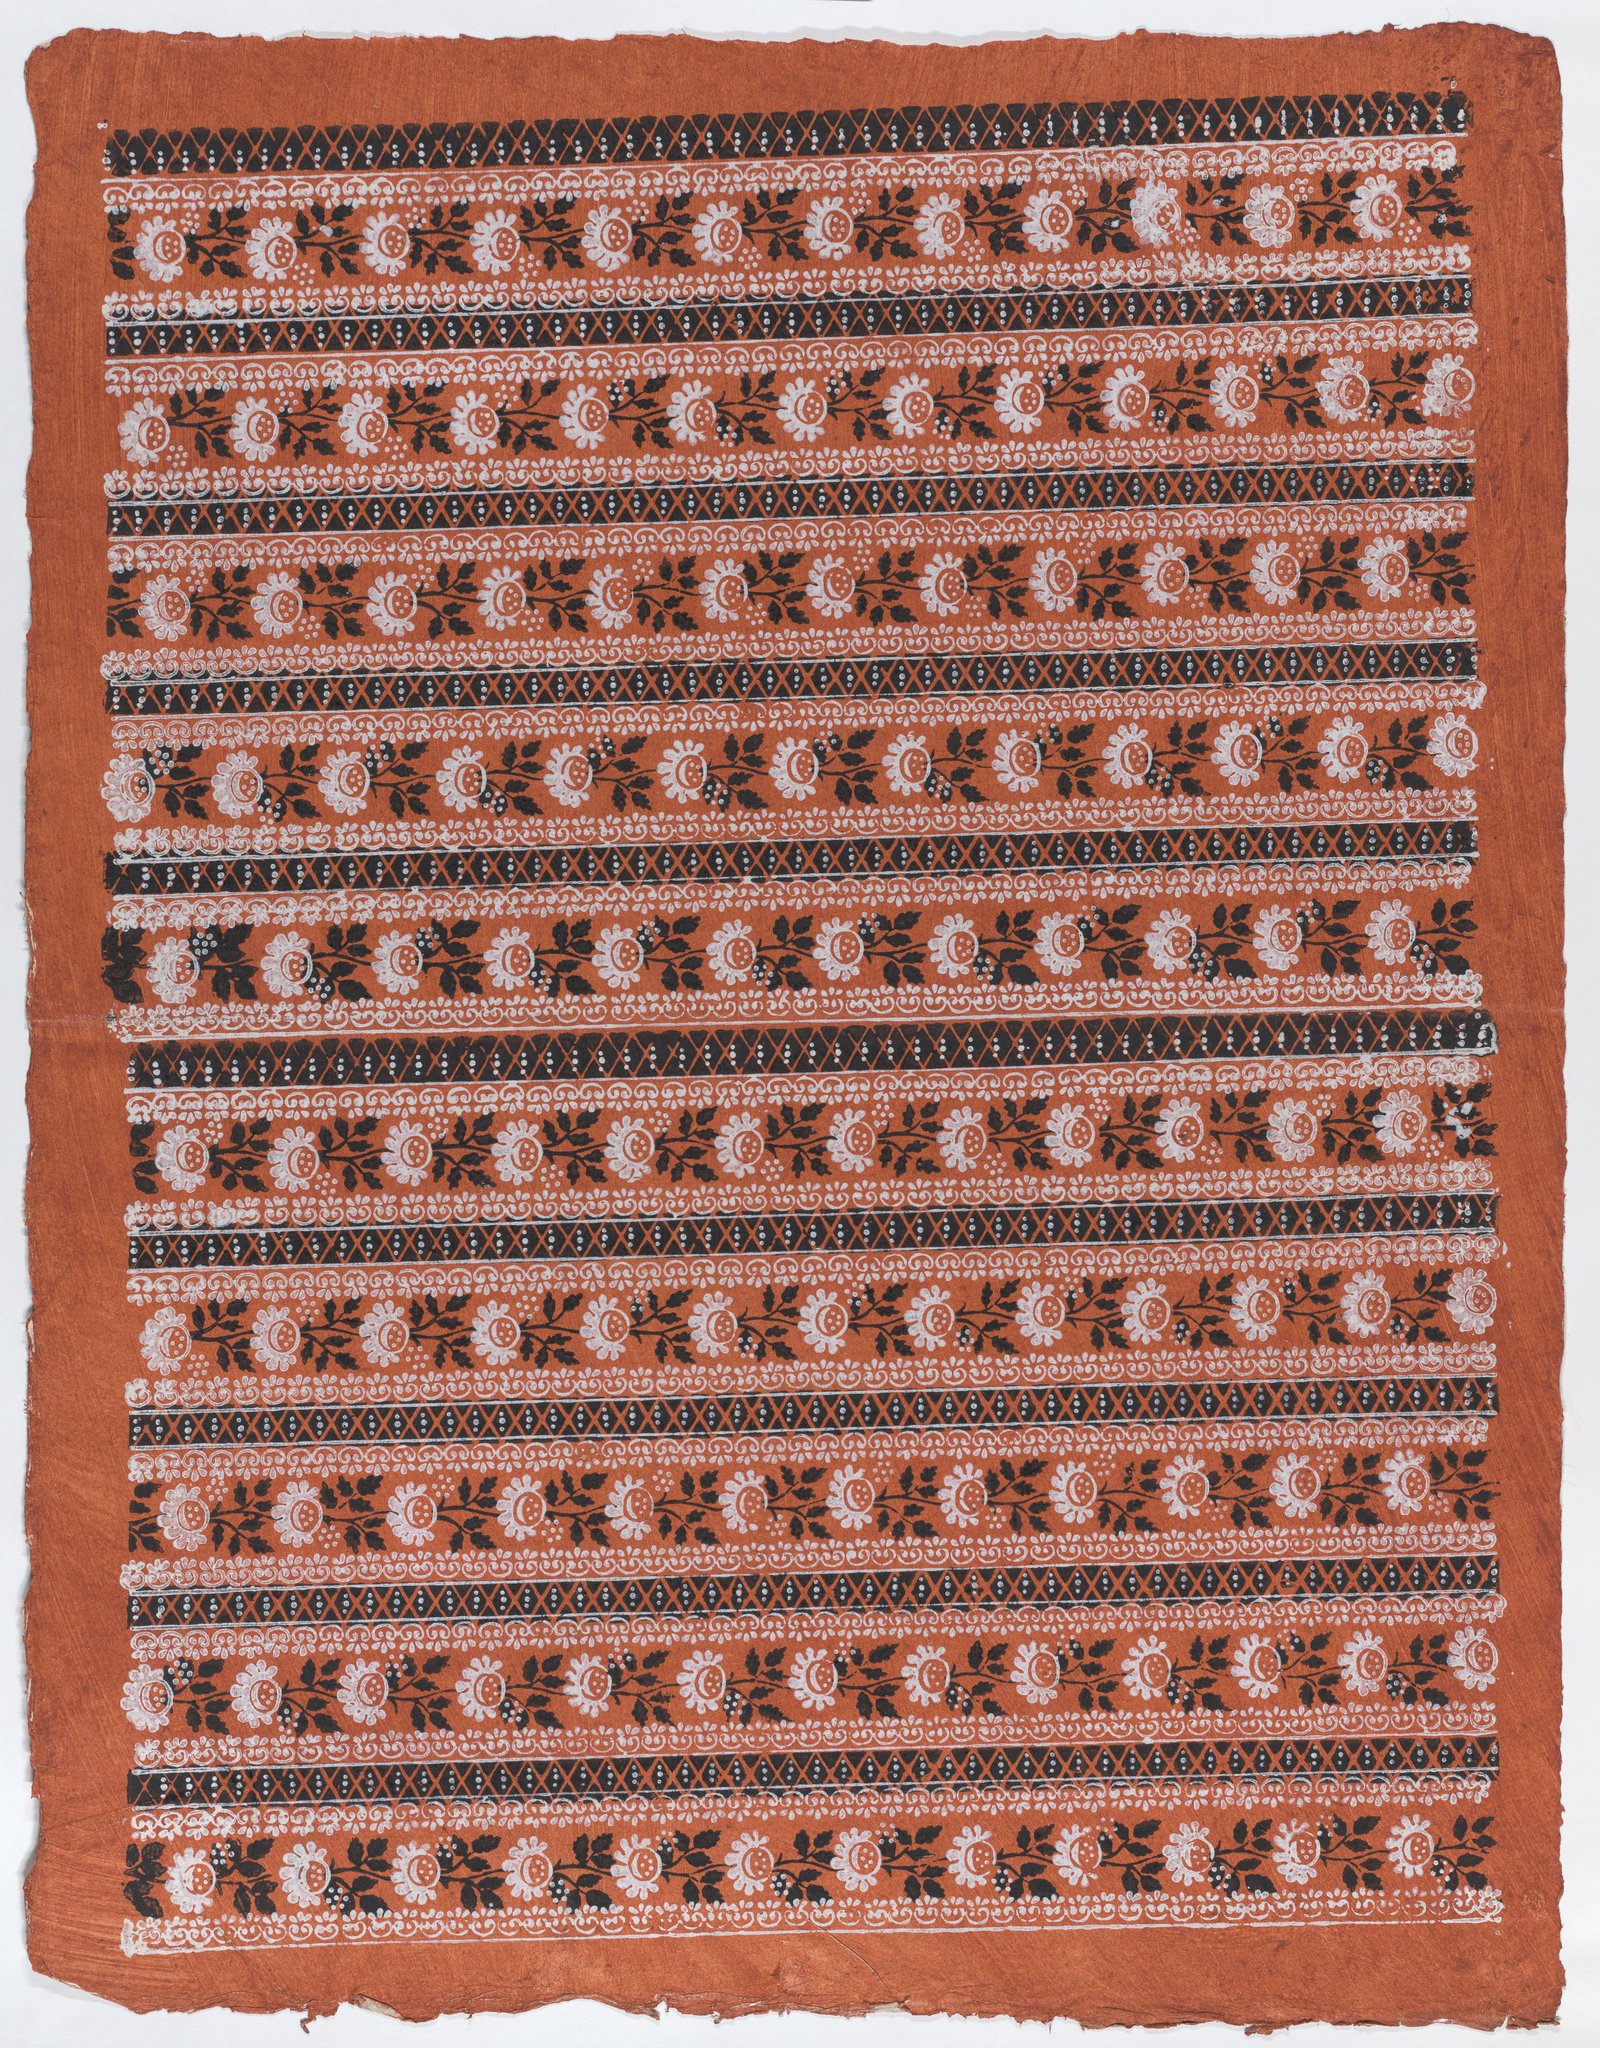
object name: print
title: Sheet with ten borders with floral patterns on orange background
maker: Anonymous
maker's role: artist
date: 1767-1866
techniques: relief print